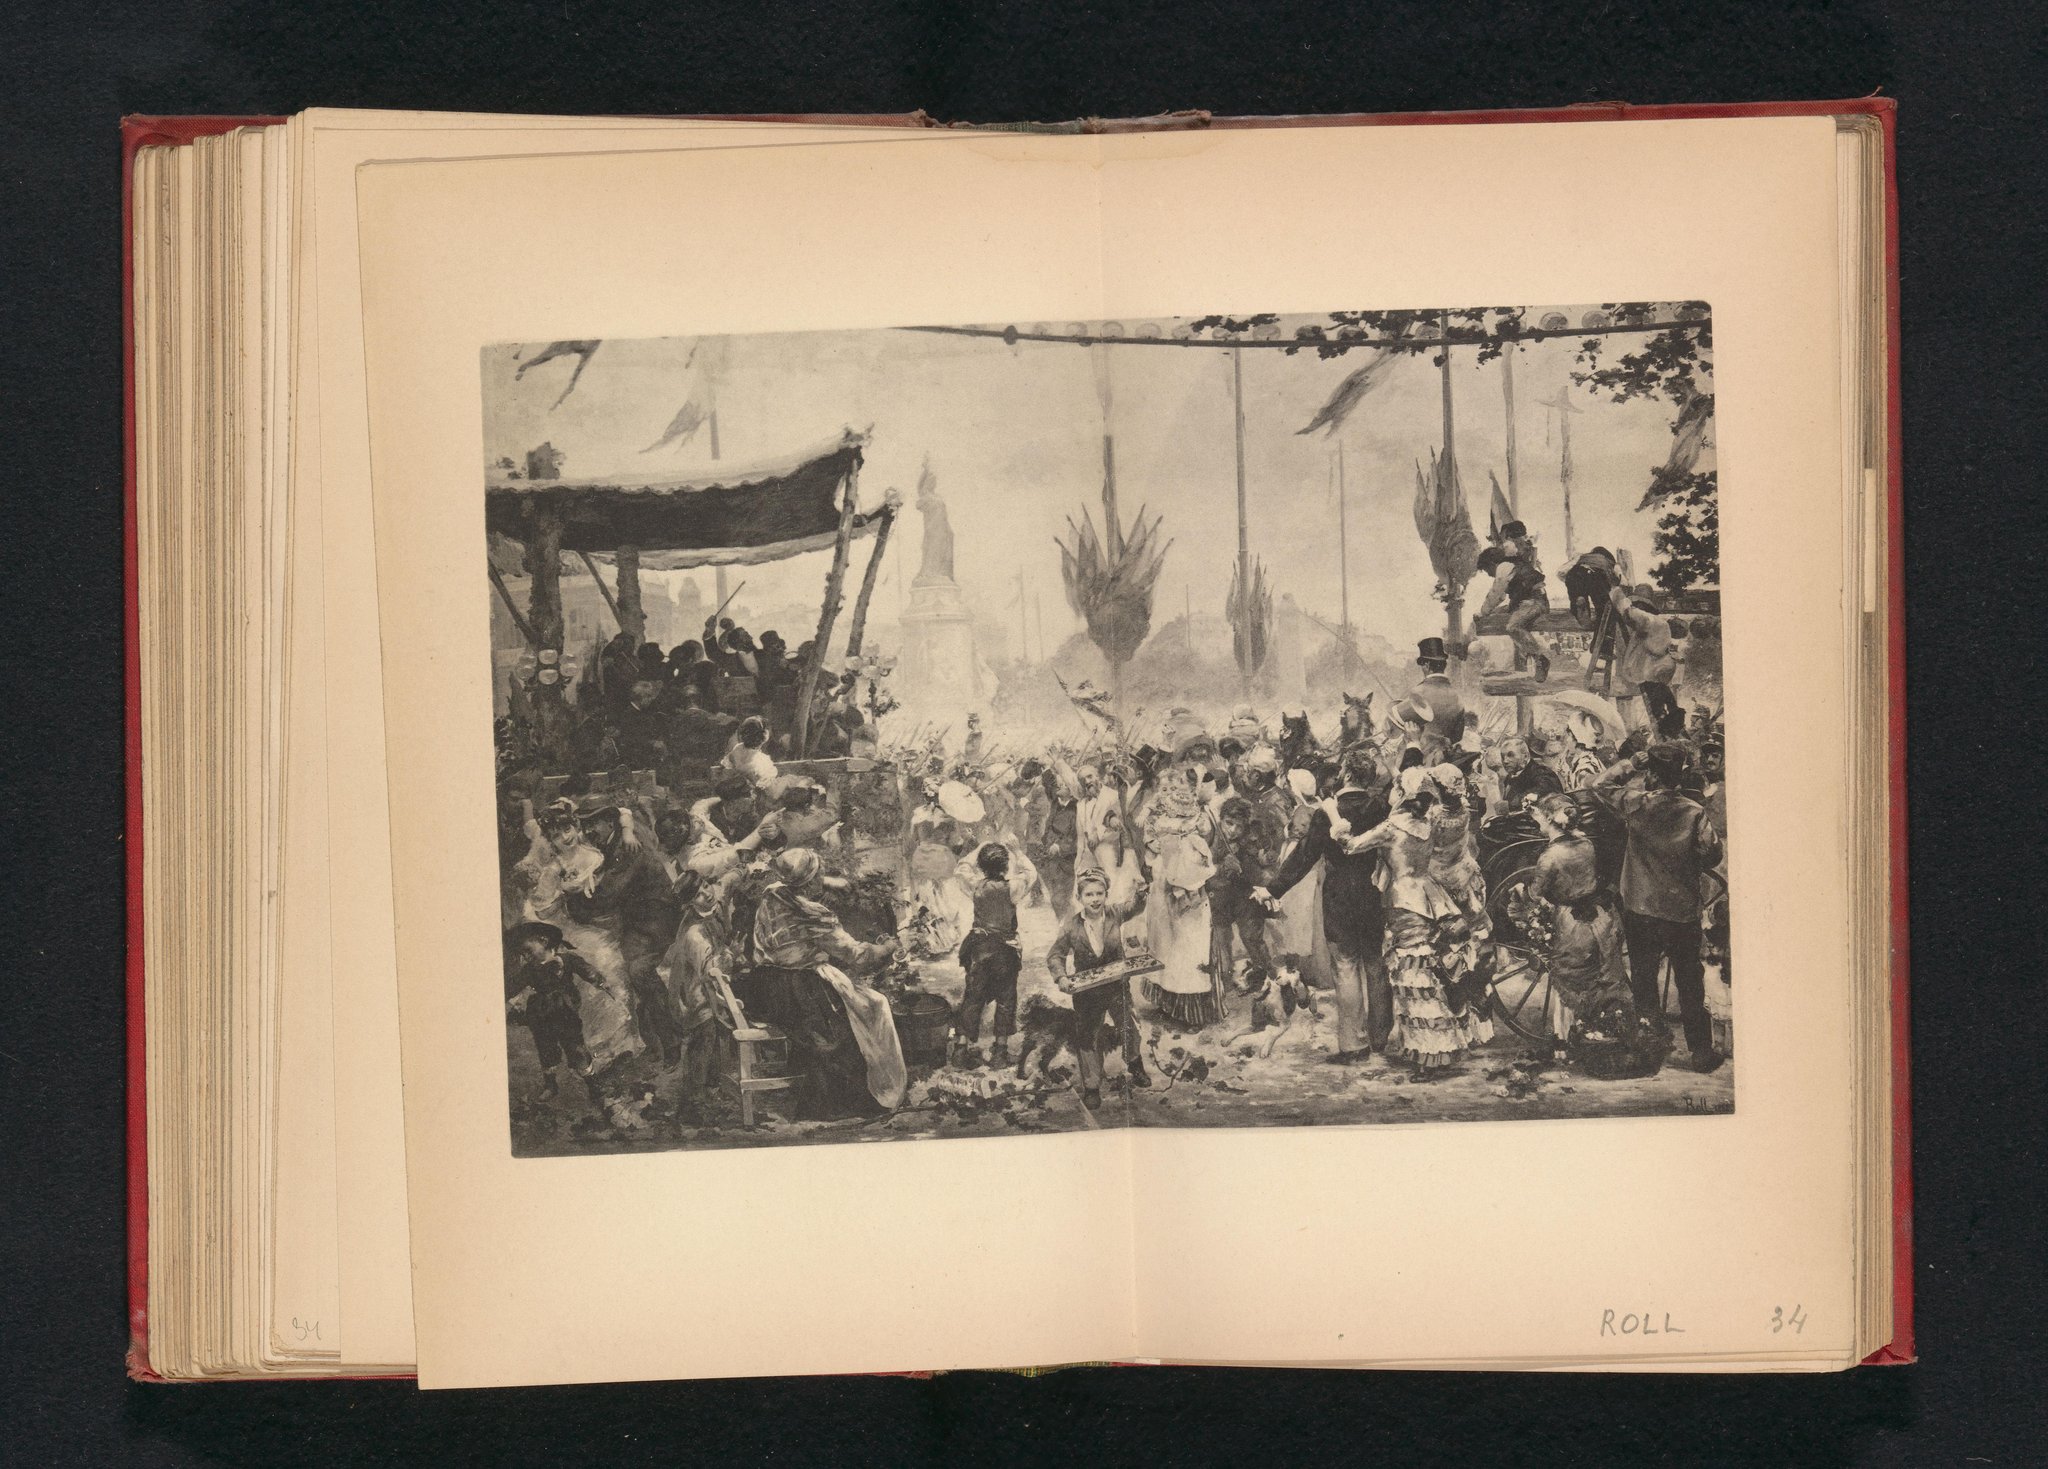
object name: photomechanical print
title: Fotoreproductie van een schilderij, voorstellende de viering van quatorze juillet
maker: alfred philippe roll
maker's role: painter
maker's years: 1846-1919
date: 1872-1882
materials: paper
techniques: photograph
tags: festivities on events of national importance